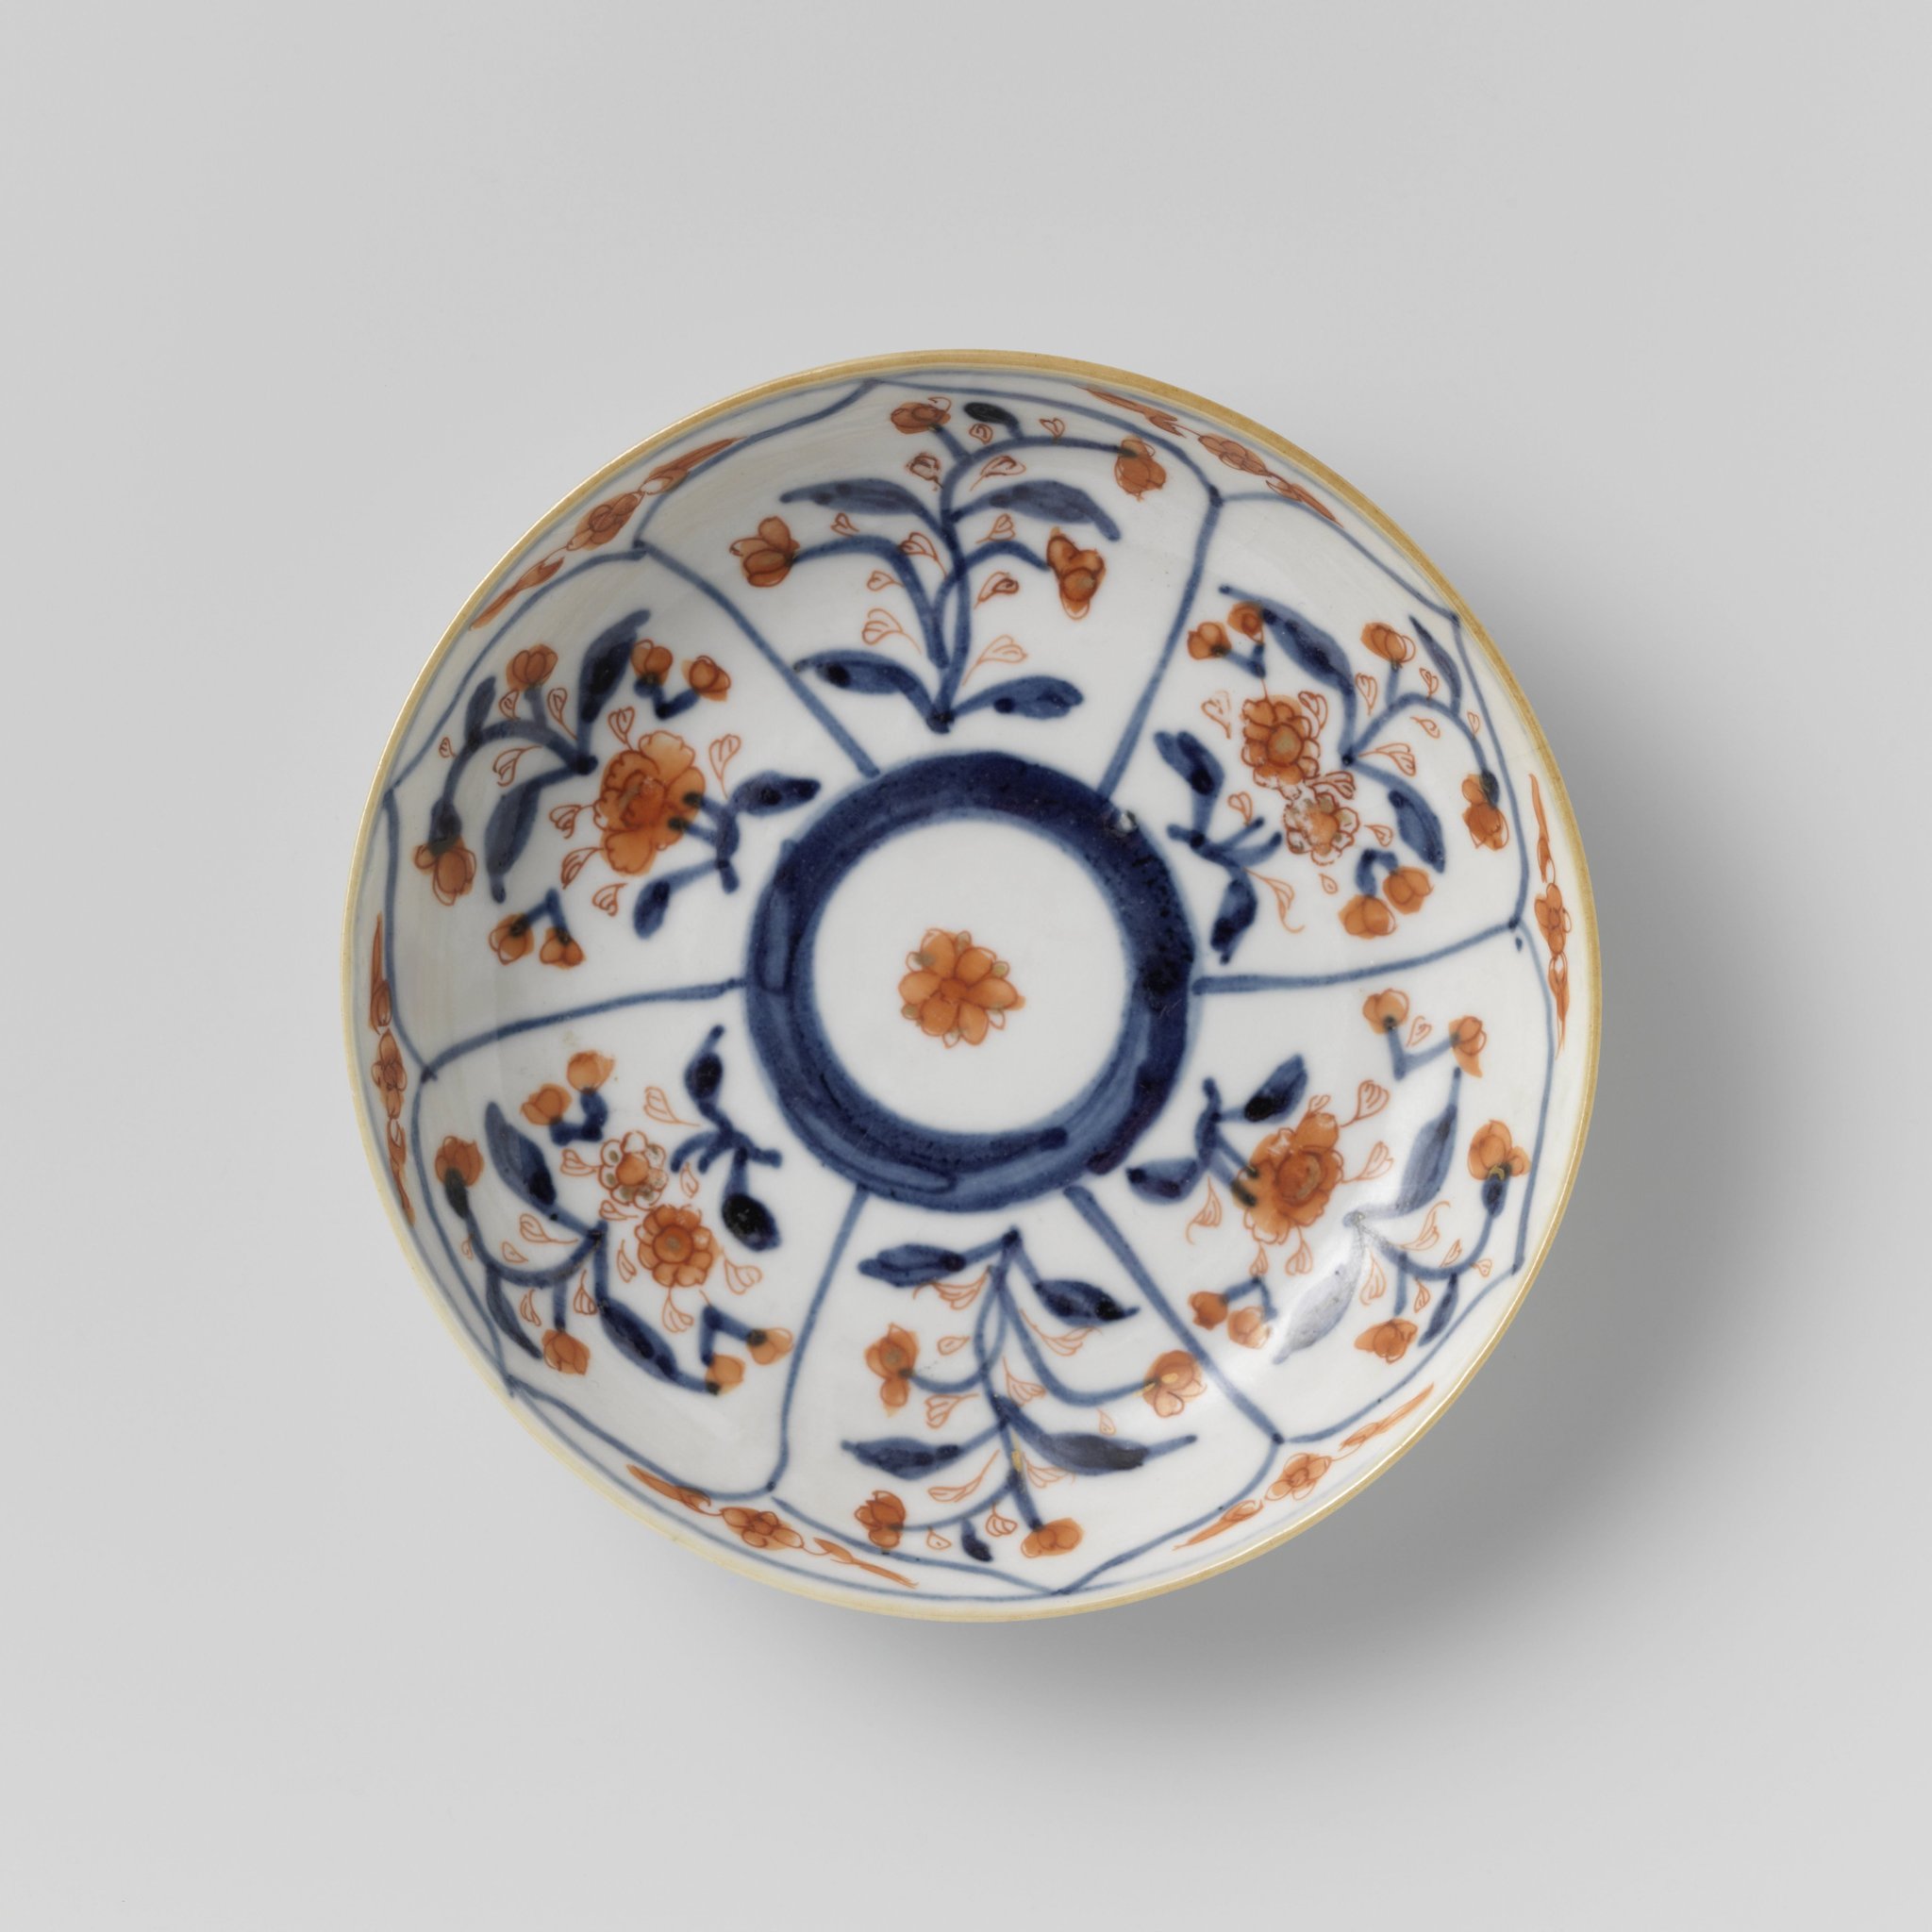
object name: kop en schotel, kop en schotel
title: Saucer with petal-shaped panel around a central medallion, filled with flower sprays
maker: Anonymous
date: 1750-1774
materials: cobalt, glaze, gold, paint, porcelain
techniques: firing, gilding, turning, vitrification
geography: china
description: Beschilderd met vakken waarin takjes in blauw, rood en goud.